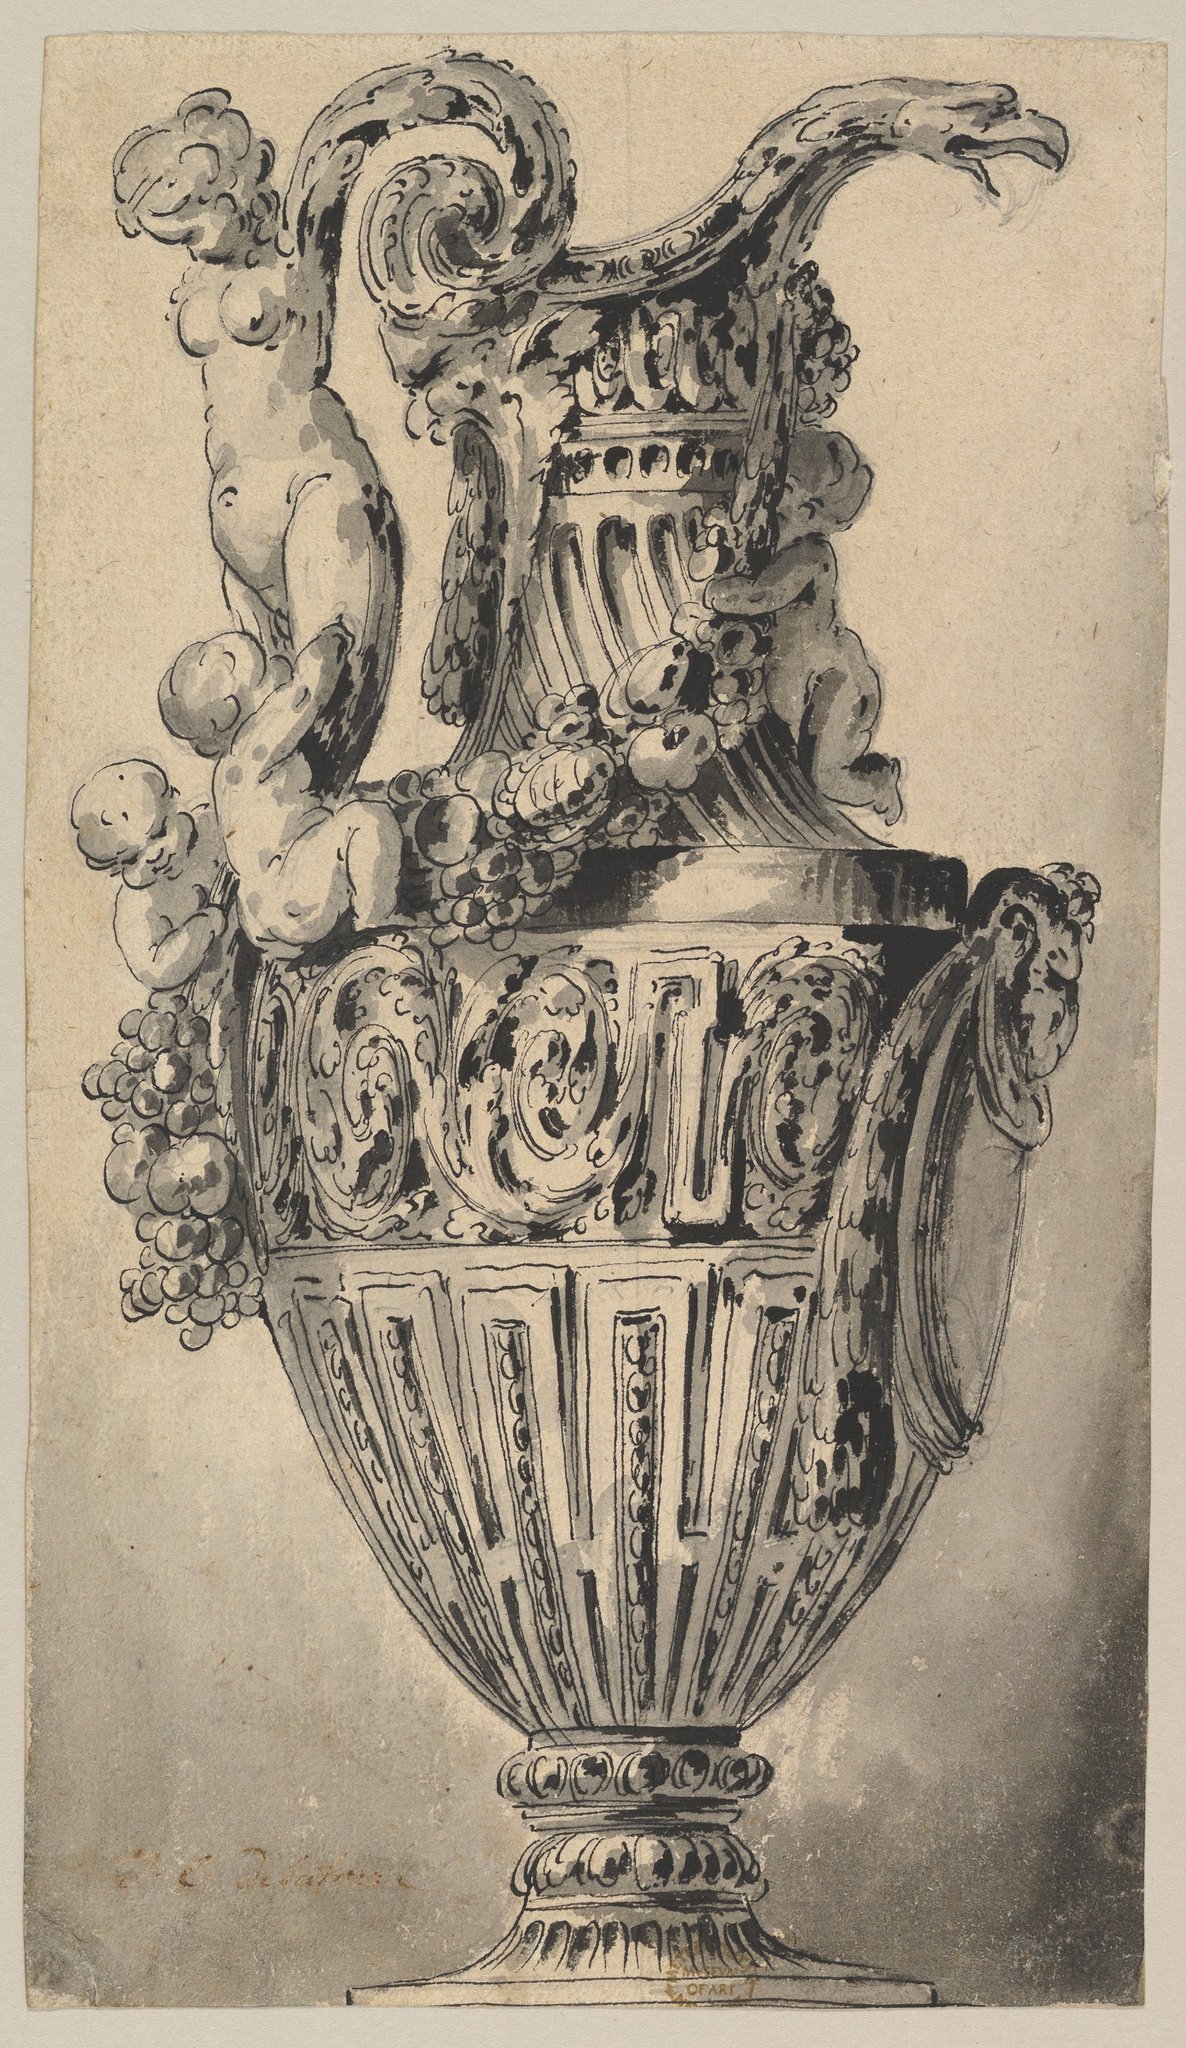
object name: drawing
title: Design for a Ewer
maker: jean charles delafosse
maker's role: artist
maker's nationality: french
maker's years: 1734-1789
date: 1734-1791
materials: ink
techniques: brush, pen, wash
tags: animals,female nudes,ewers